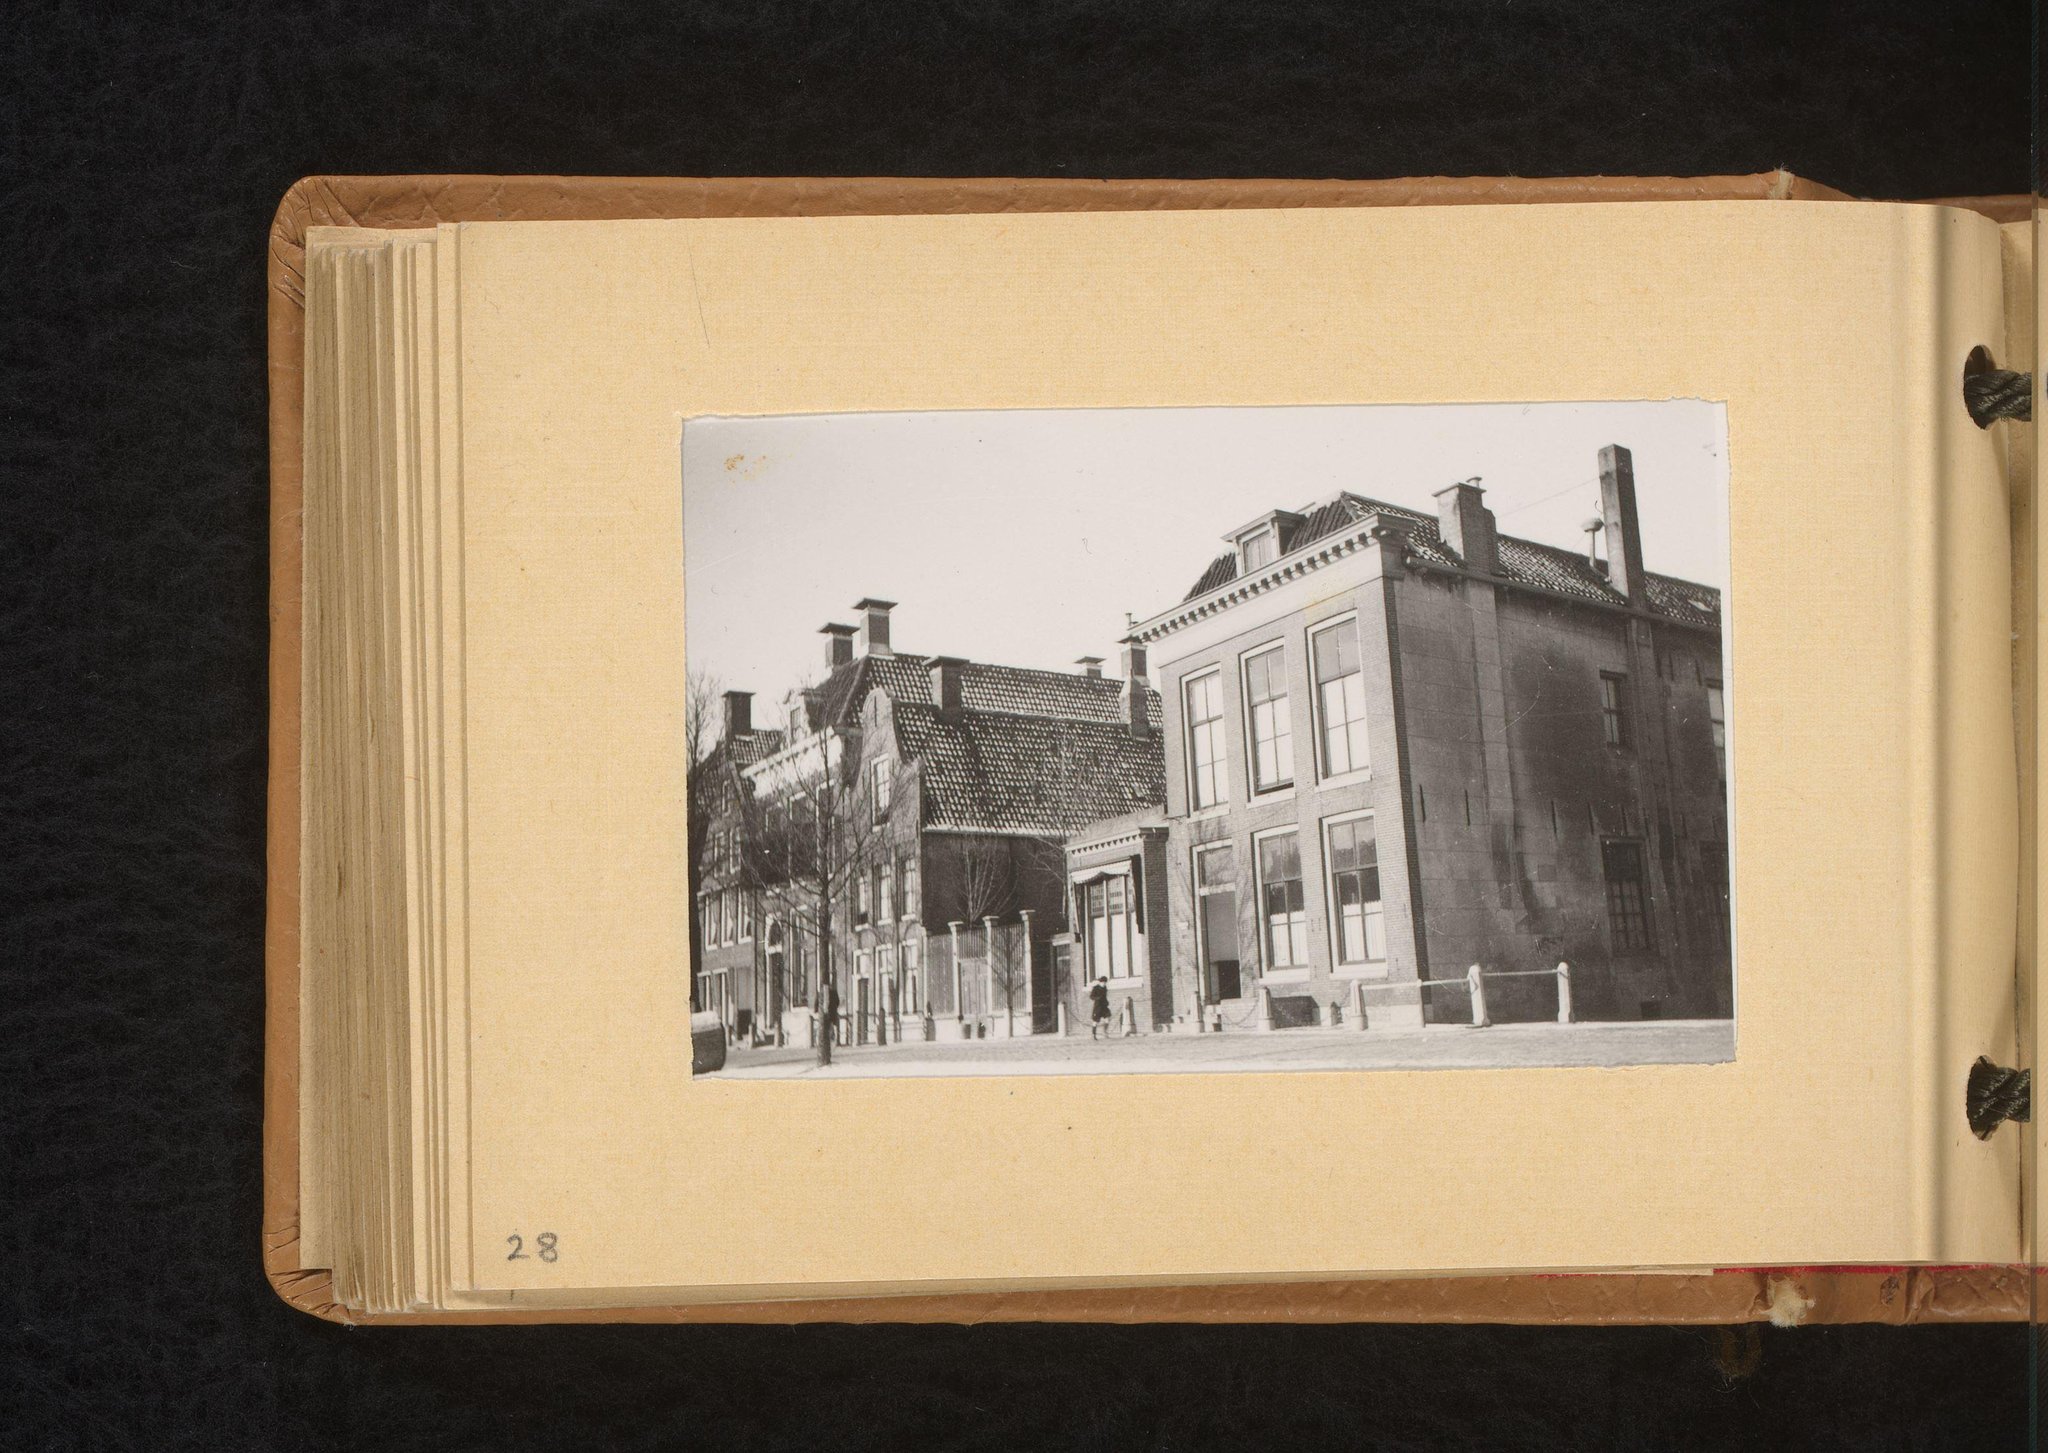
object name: album leaf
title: Gebouw van de Kriegsmarine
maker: Anonymous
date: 1940-1943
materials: paper, photographic support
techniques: gelatin silver print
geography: netherlands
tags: shelter ~ military service, occupation ~ war, public road (+ city(-scape) with figures, staffage), netherlands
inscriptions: name: ‘Fotob. Zegel 255’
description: Albumblad met een foto van een rij huizen in een Nederlandse stad met rechts het gebouw van de Kriegsmarie (Dienststelle 23 443). Onderdeel van een klein album van de Kriegsmarine in Nederland.